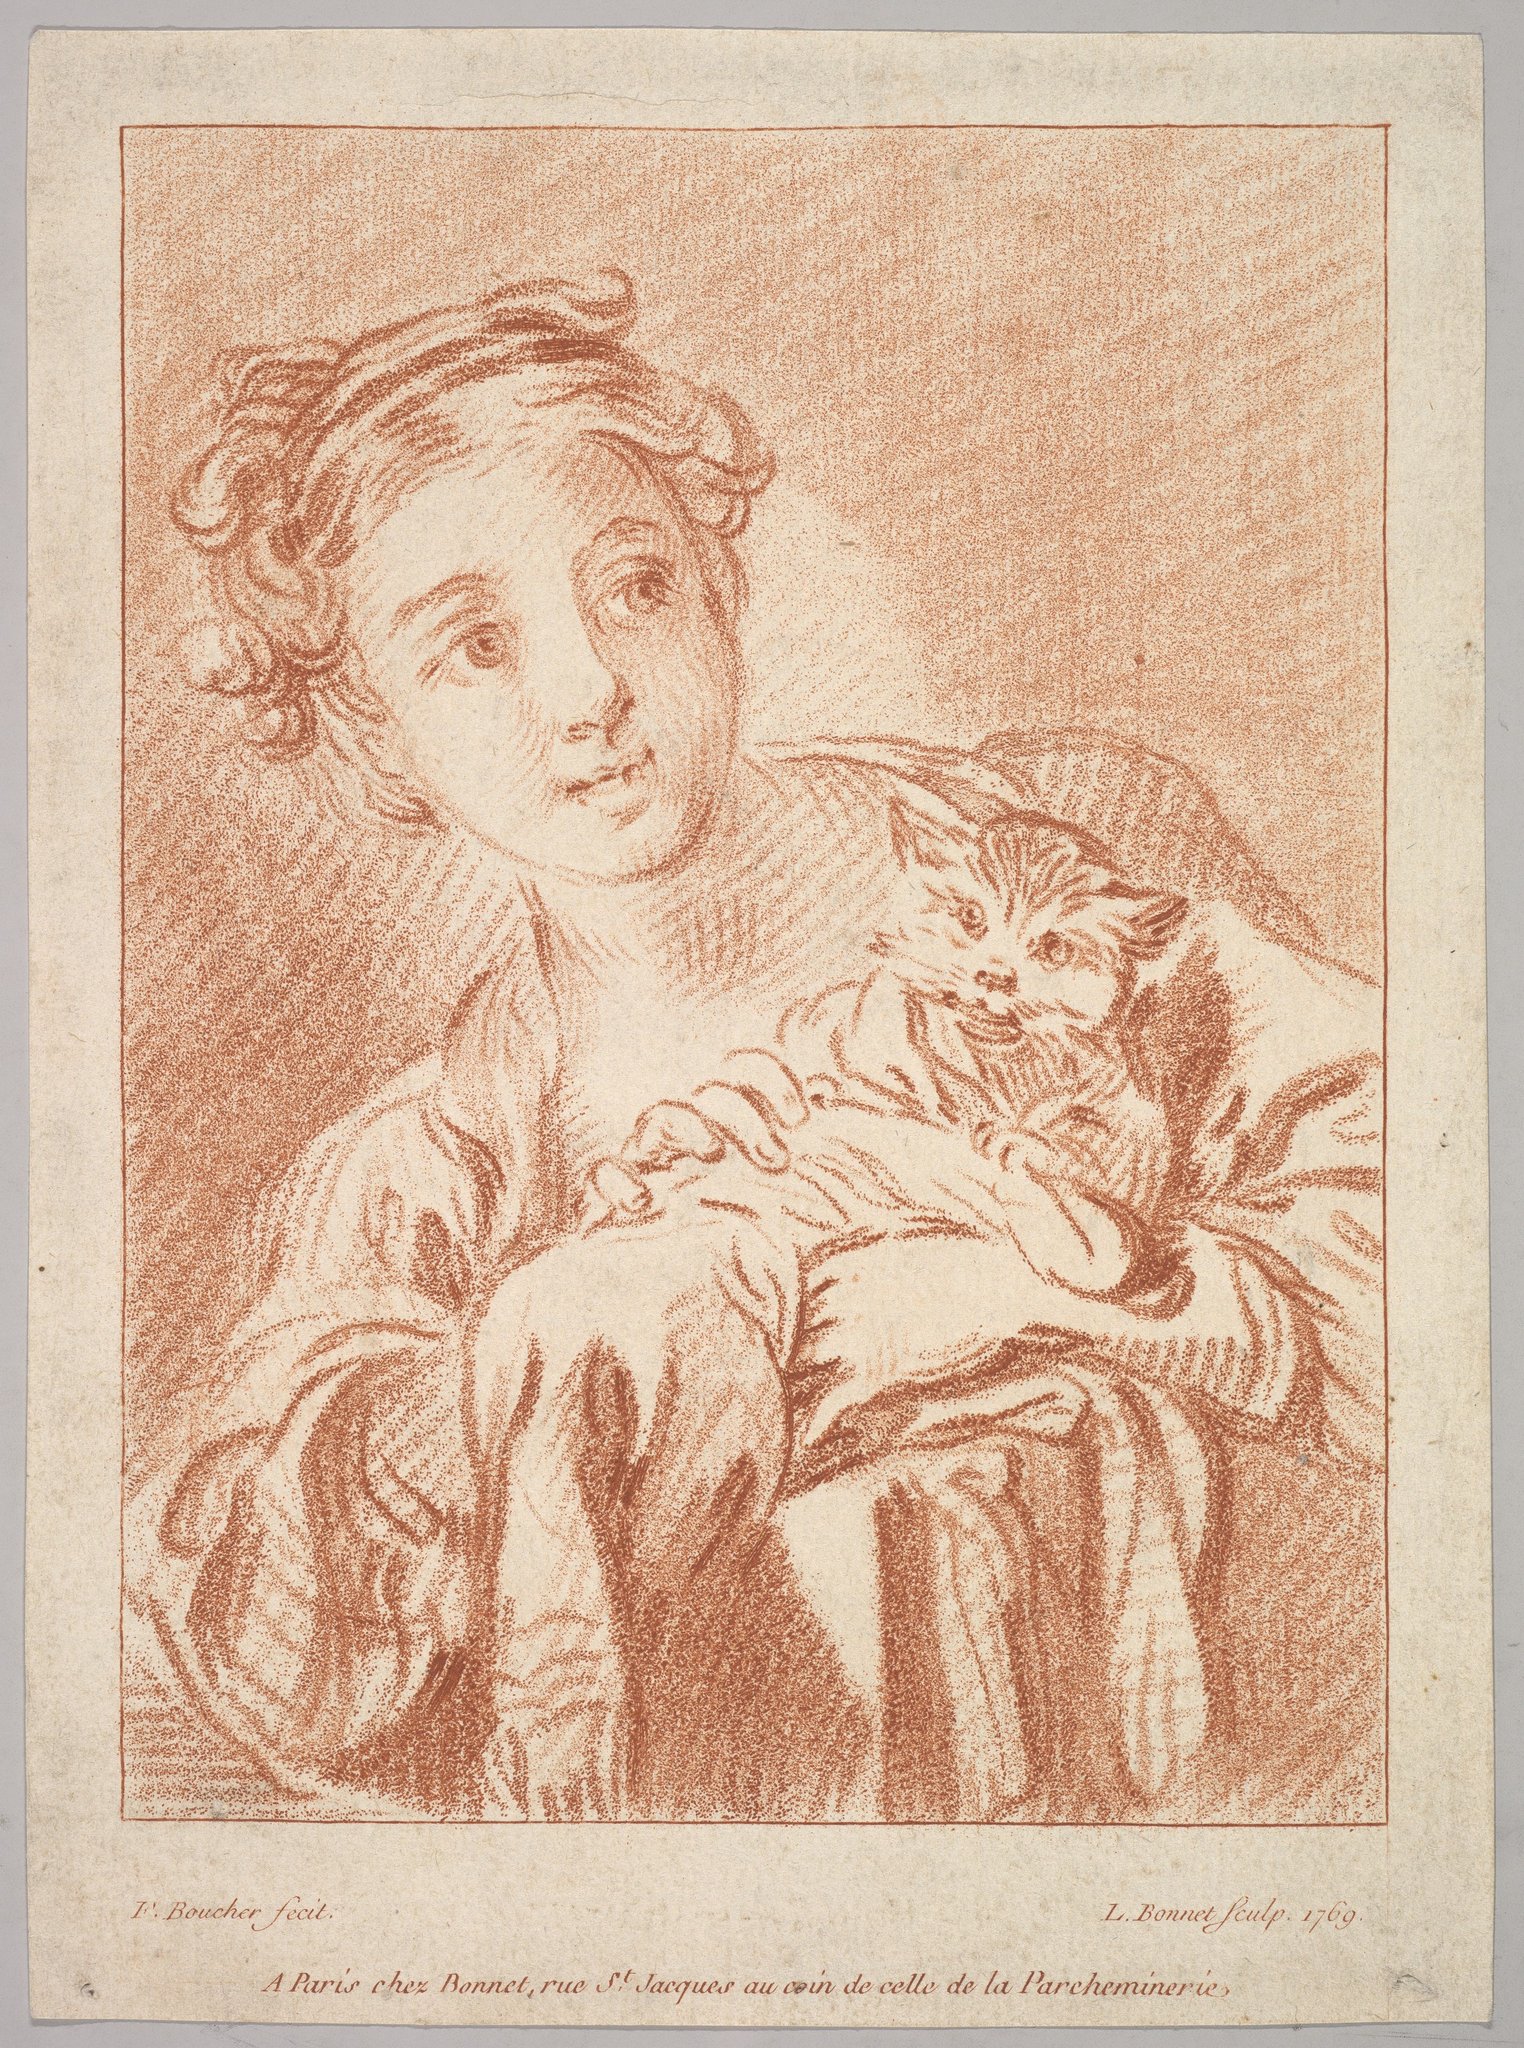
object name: print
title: A Young Girl holding a Cat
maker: louis marin bonnet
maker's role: artist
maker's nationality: french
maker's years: 1736-1793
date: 1769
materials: ink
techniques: printmaking, engraving, printing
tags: girls,cats